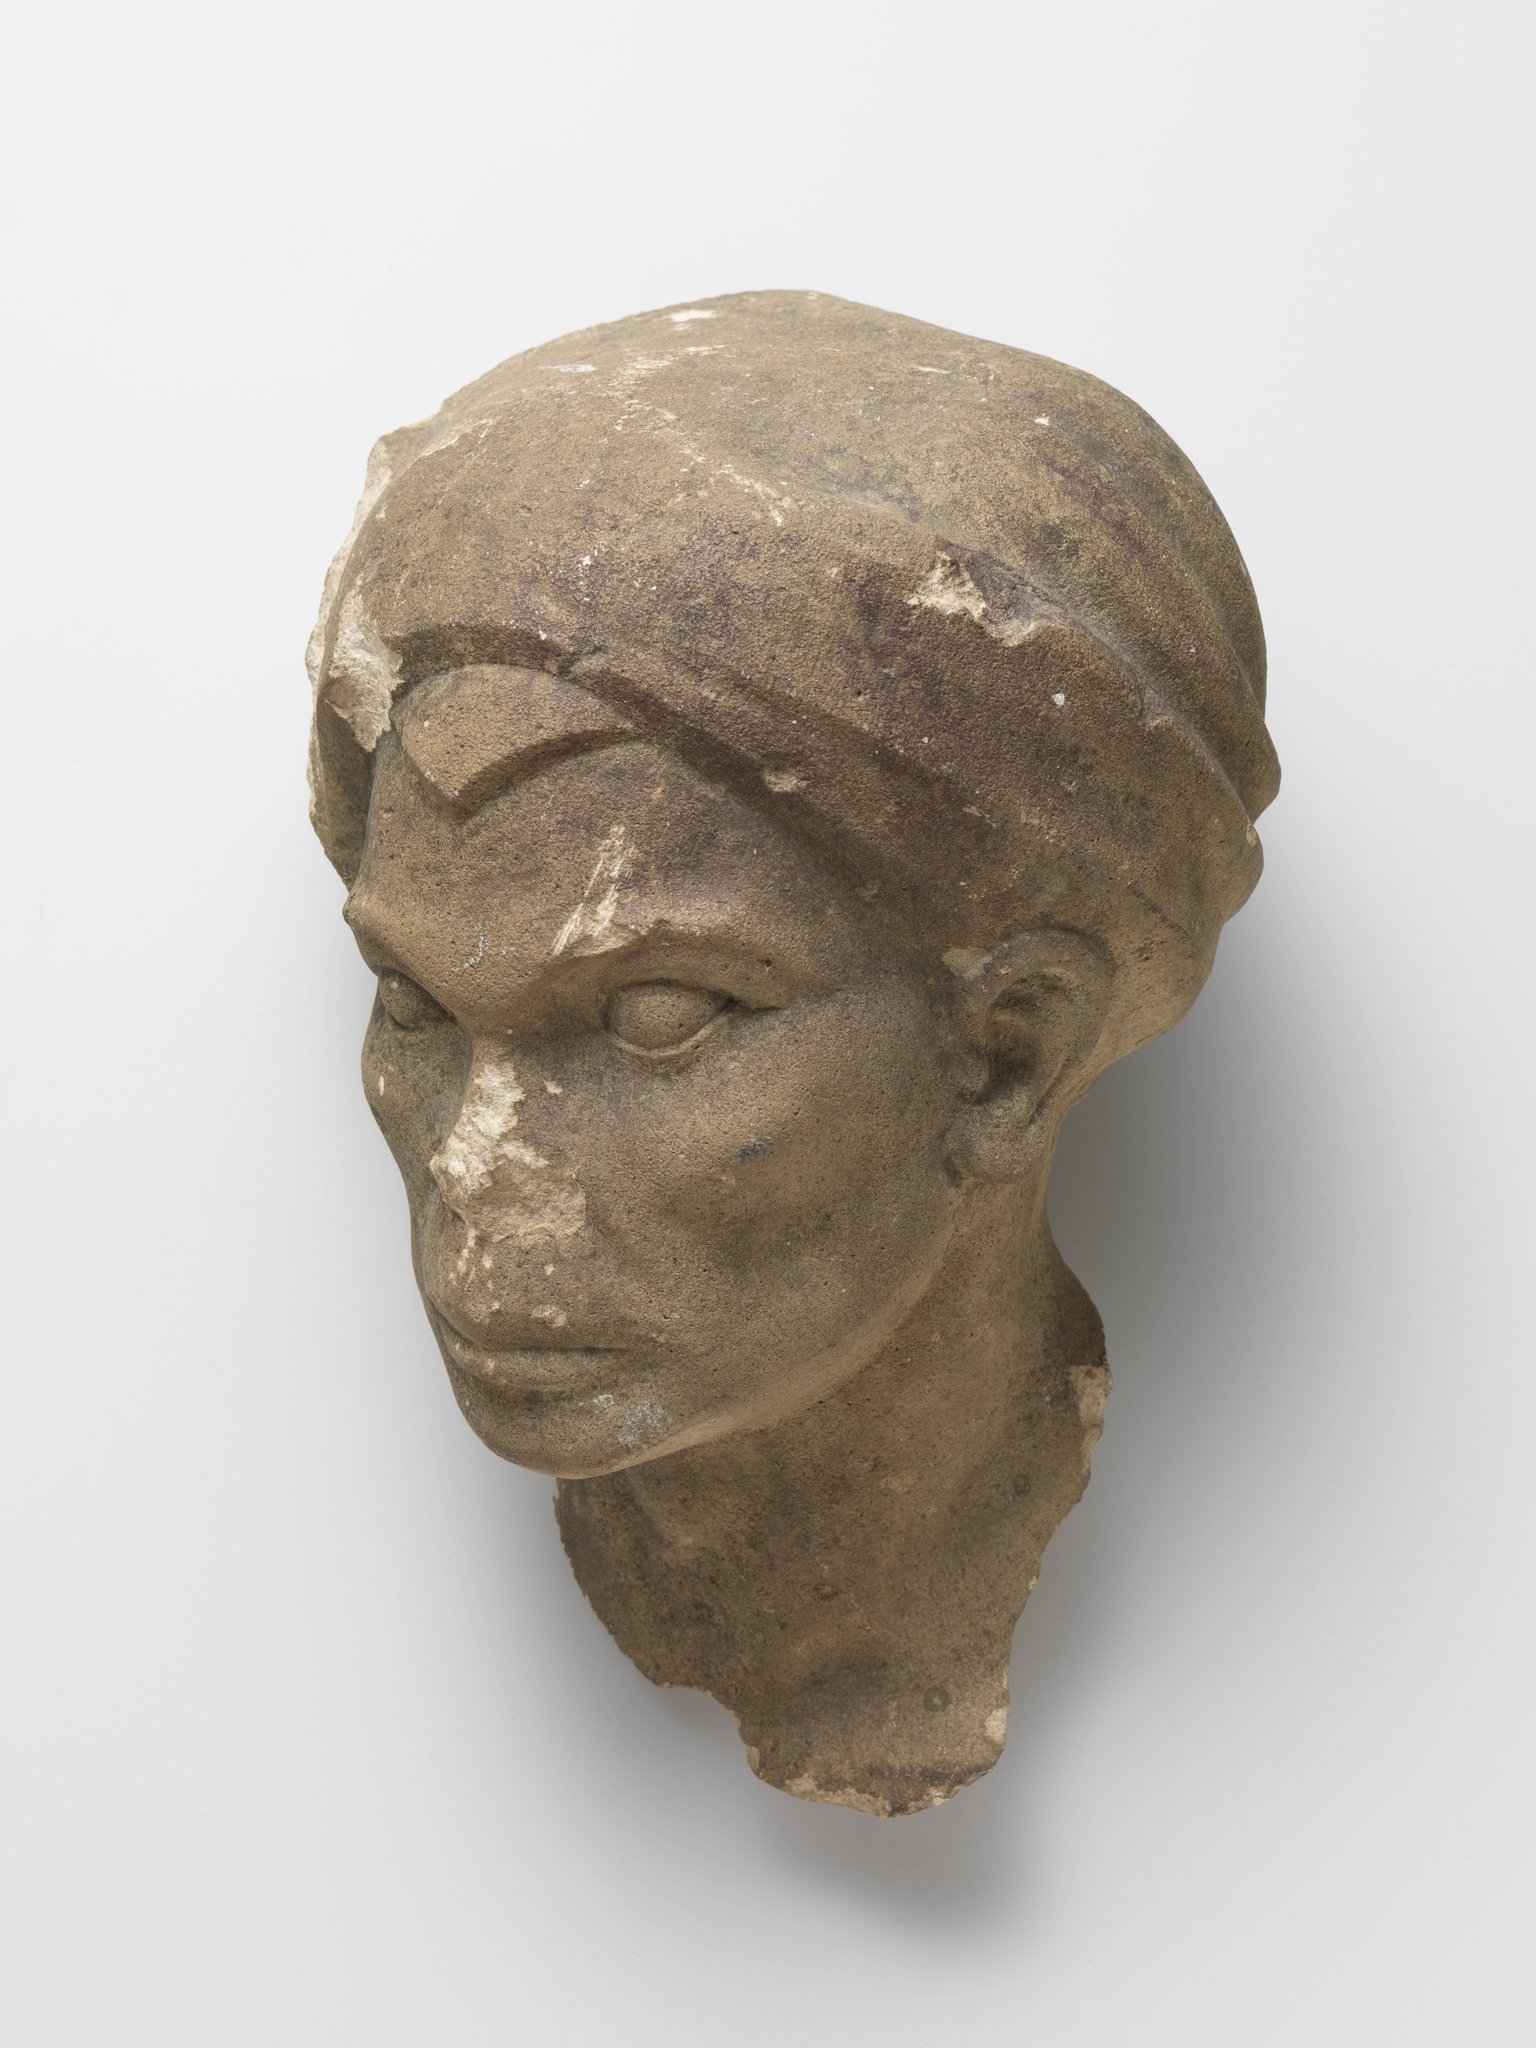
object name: figure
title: Kop van Javaan van Van Heutsz monument Batavia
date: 1932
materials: stone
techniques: hewing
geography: batavia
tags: dutch east indies, the, batavia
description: The Van Heutsz monument in Batavia was twelve metres high, twenty metres deep and sixteen metres across.